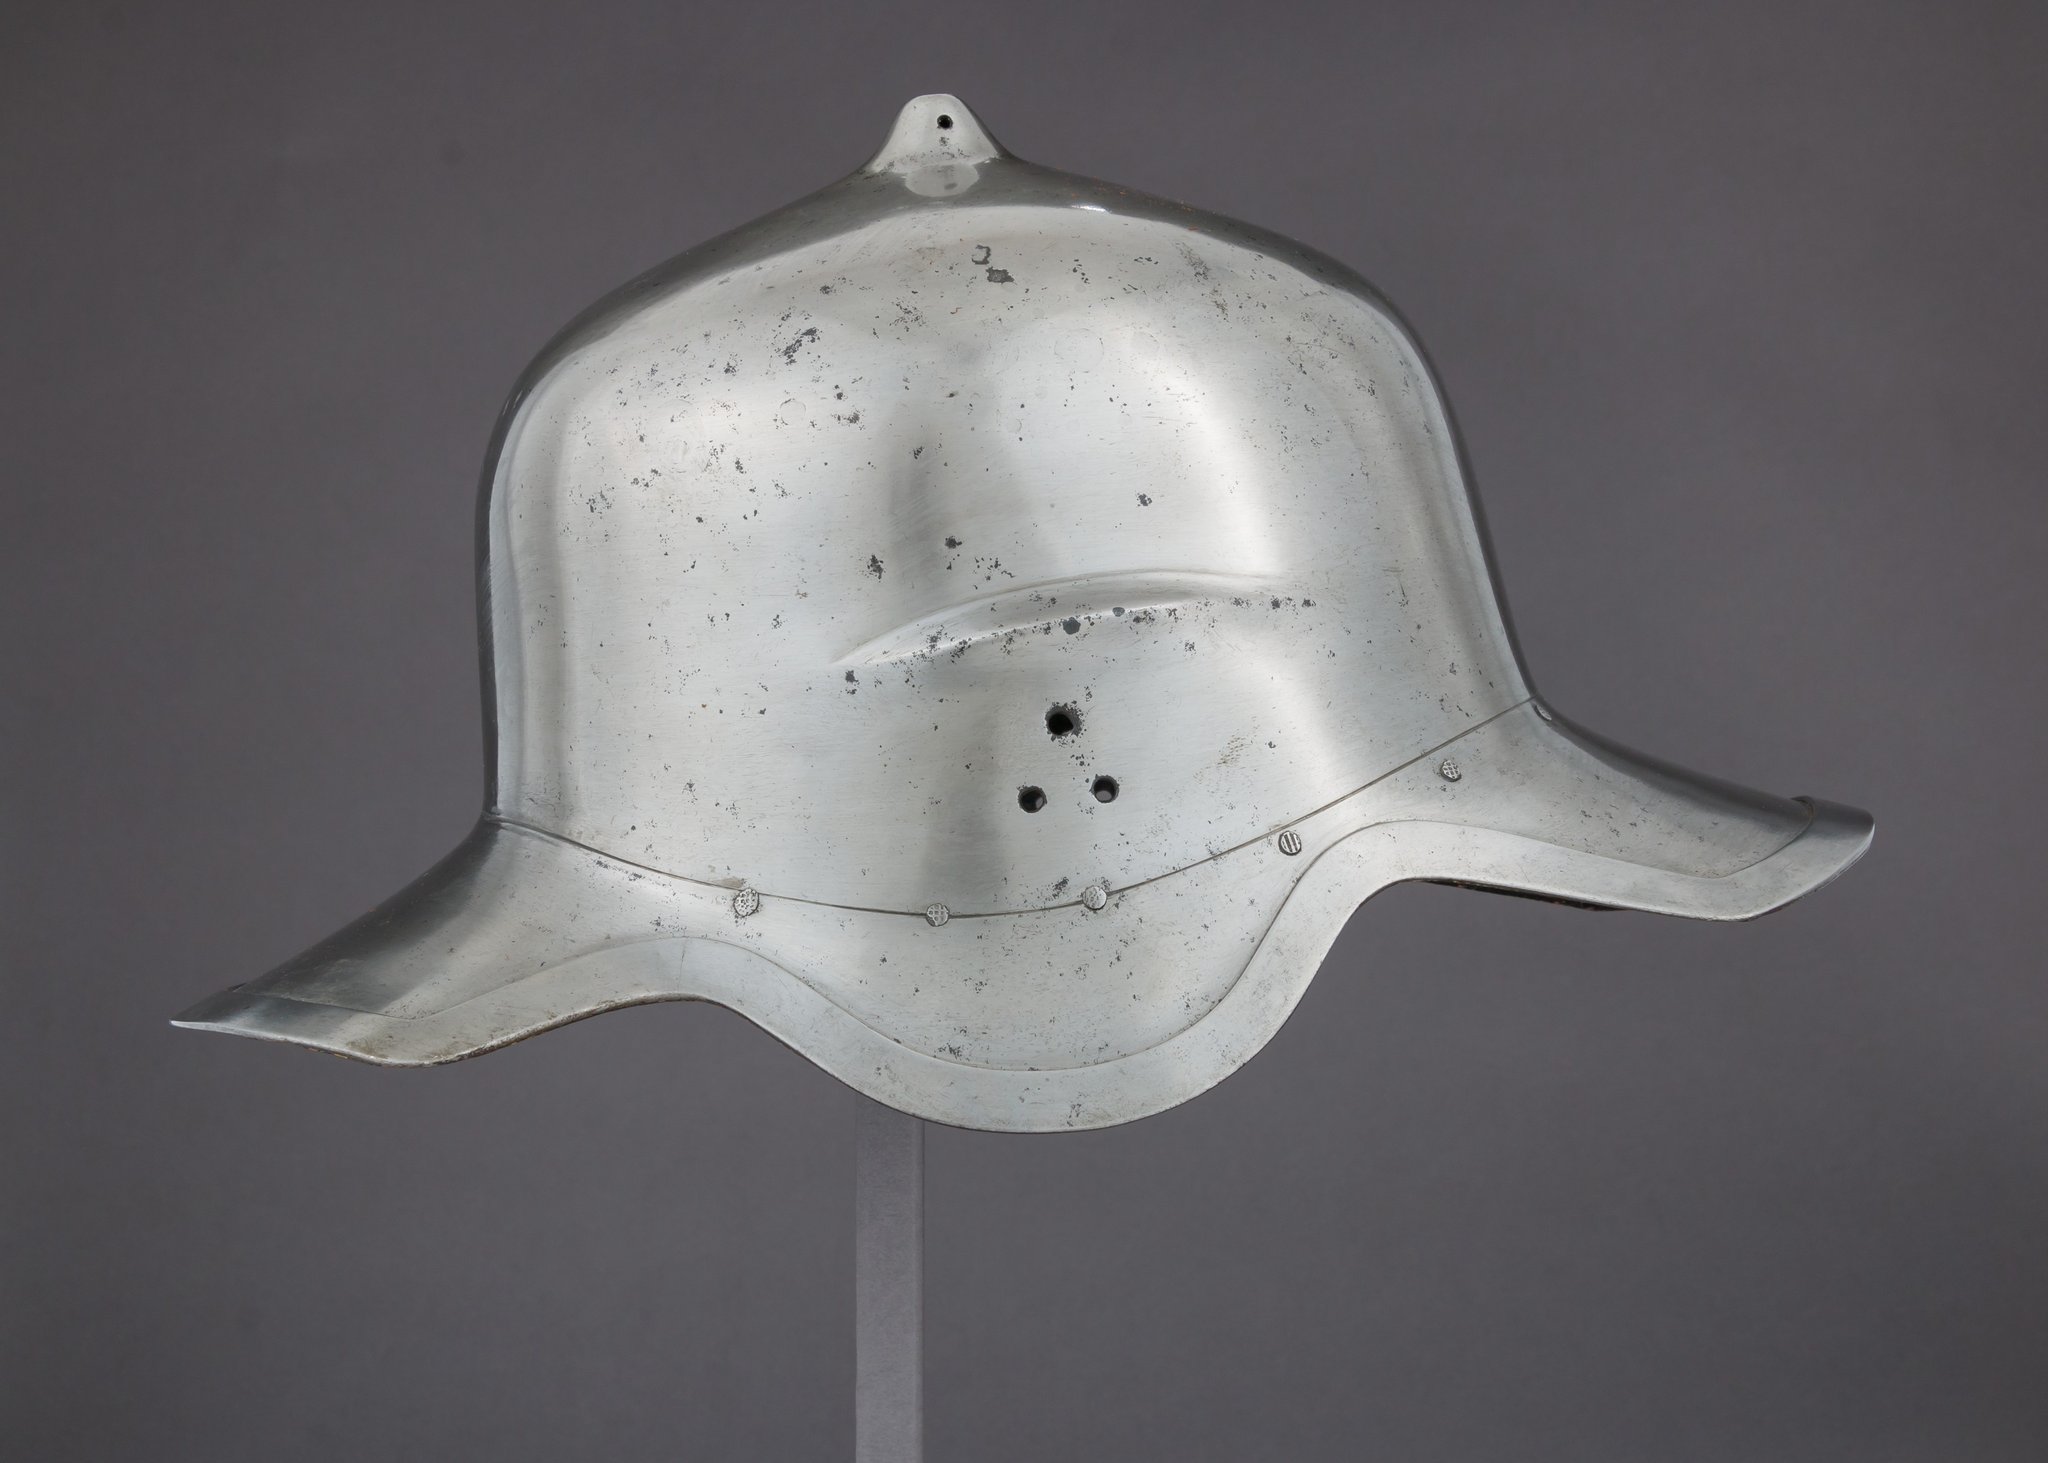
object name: war hat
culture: french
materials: leather, pigment, steel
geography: france